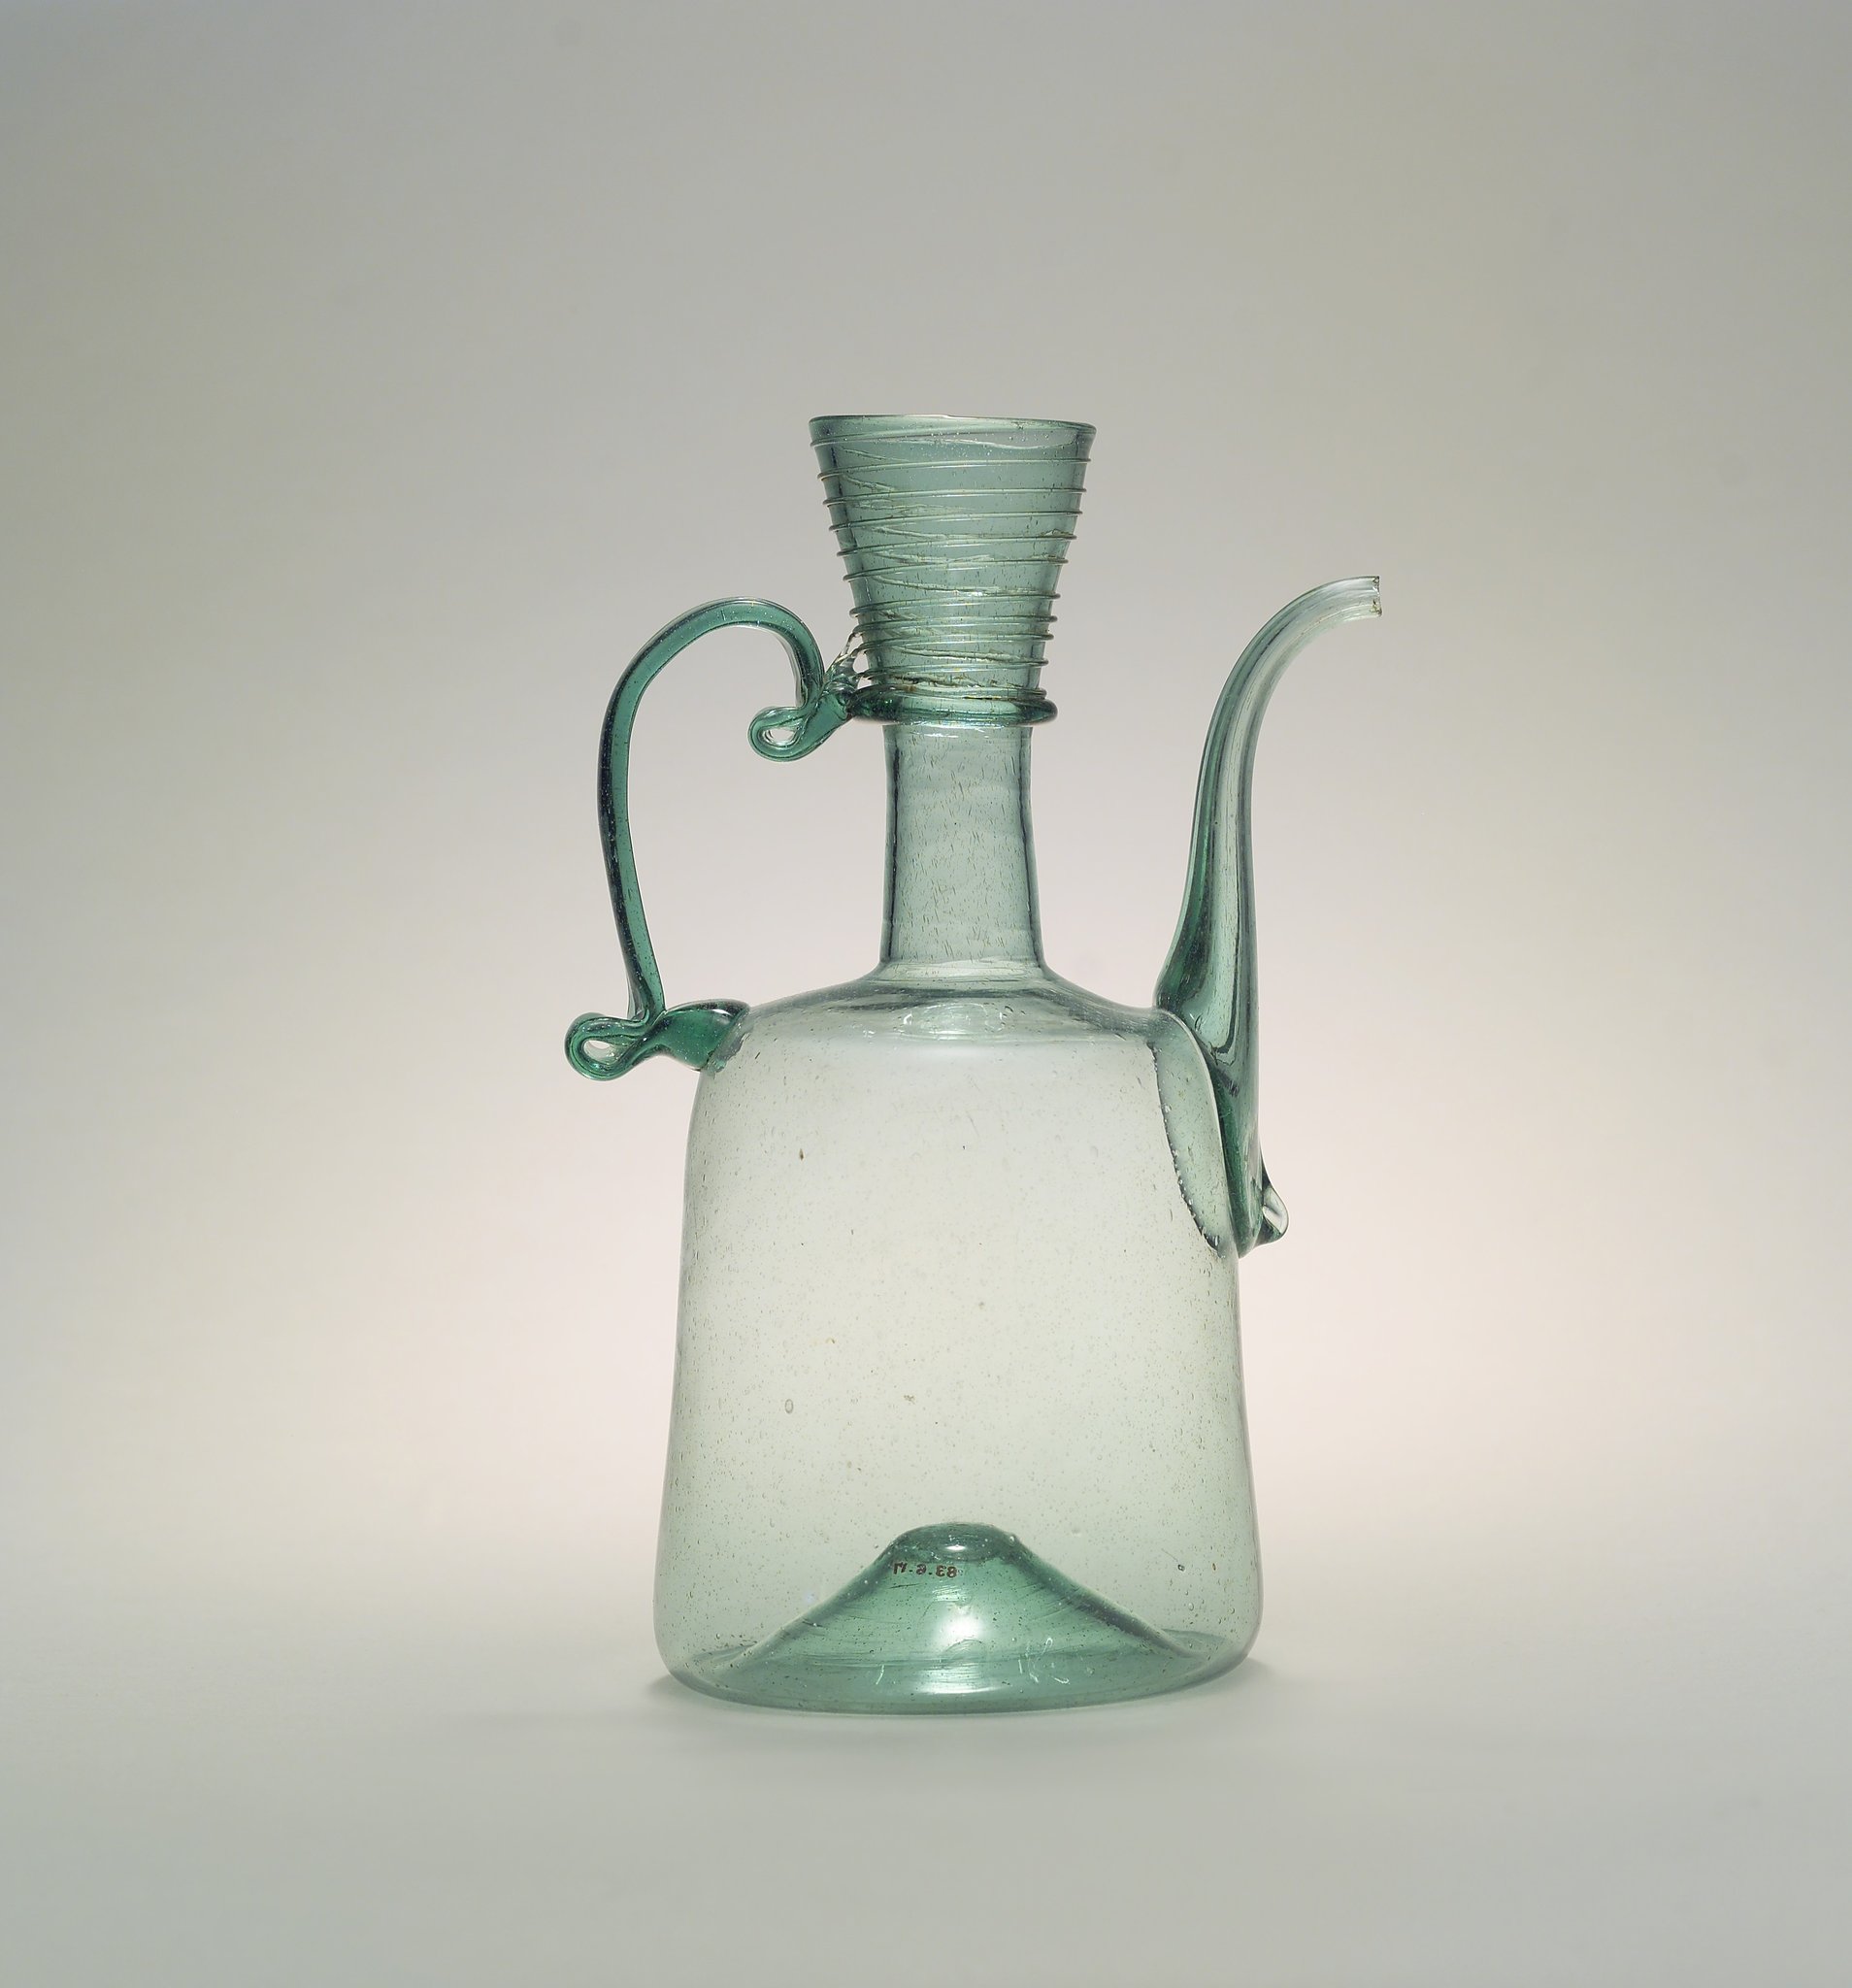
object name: ewer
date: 1801-1900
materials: glass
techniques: glassblowing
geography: iran